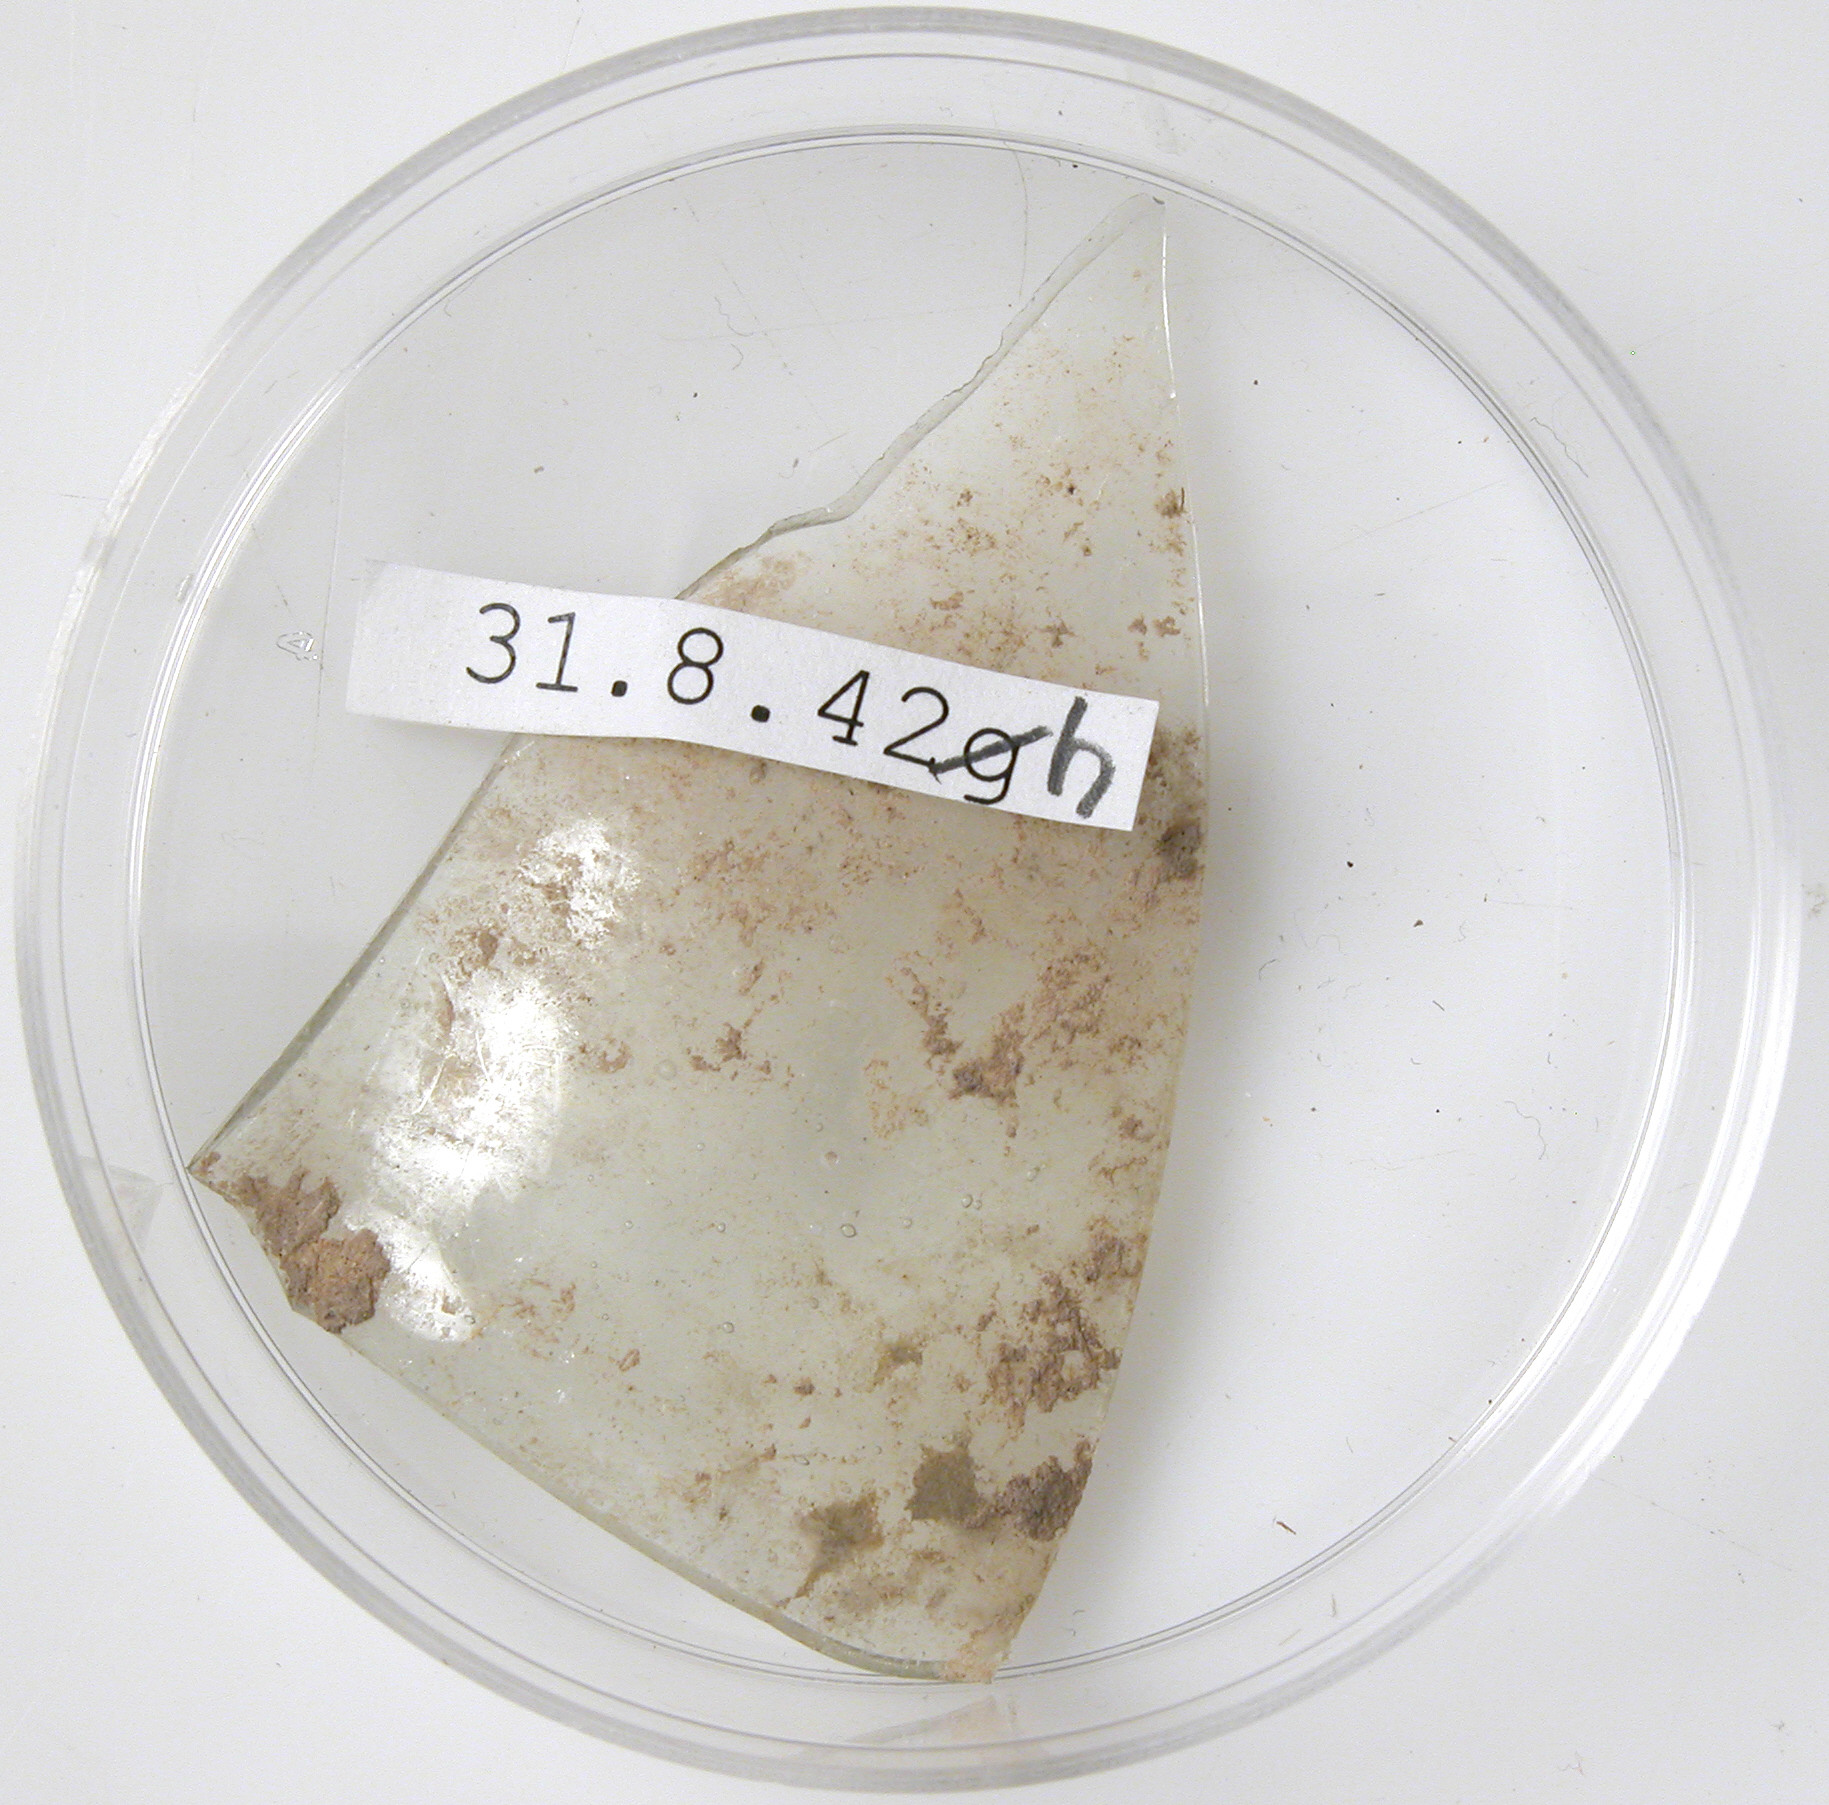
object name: fragment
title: Glass Fragment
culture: coptic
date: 301-400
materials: glass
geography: egypt